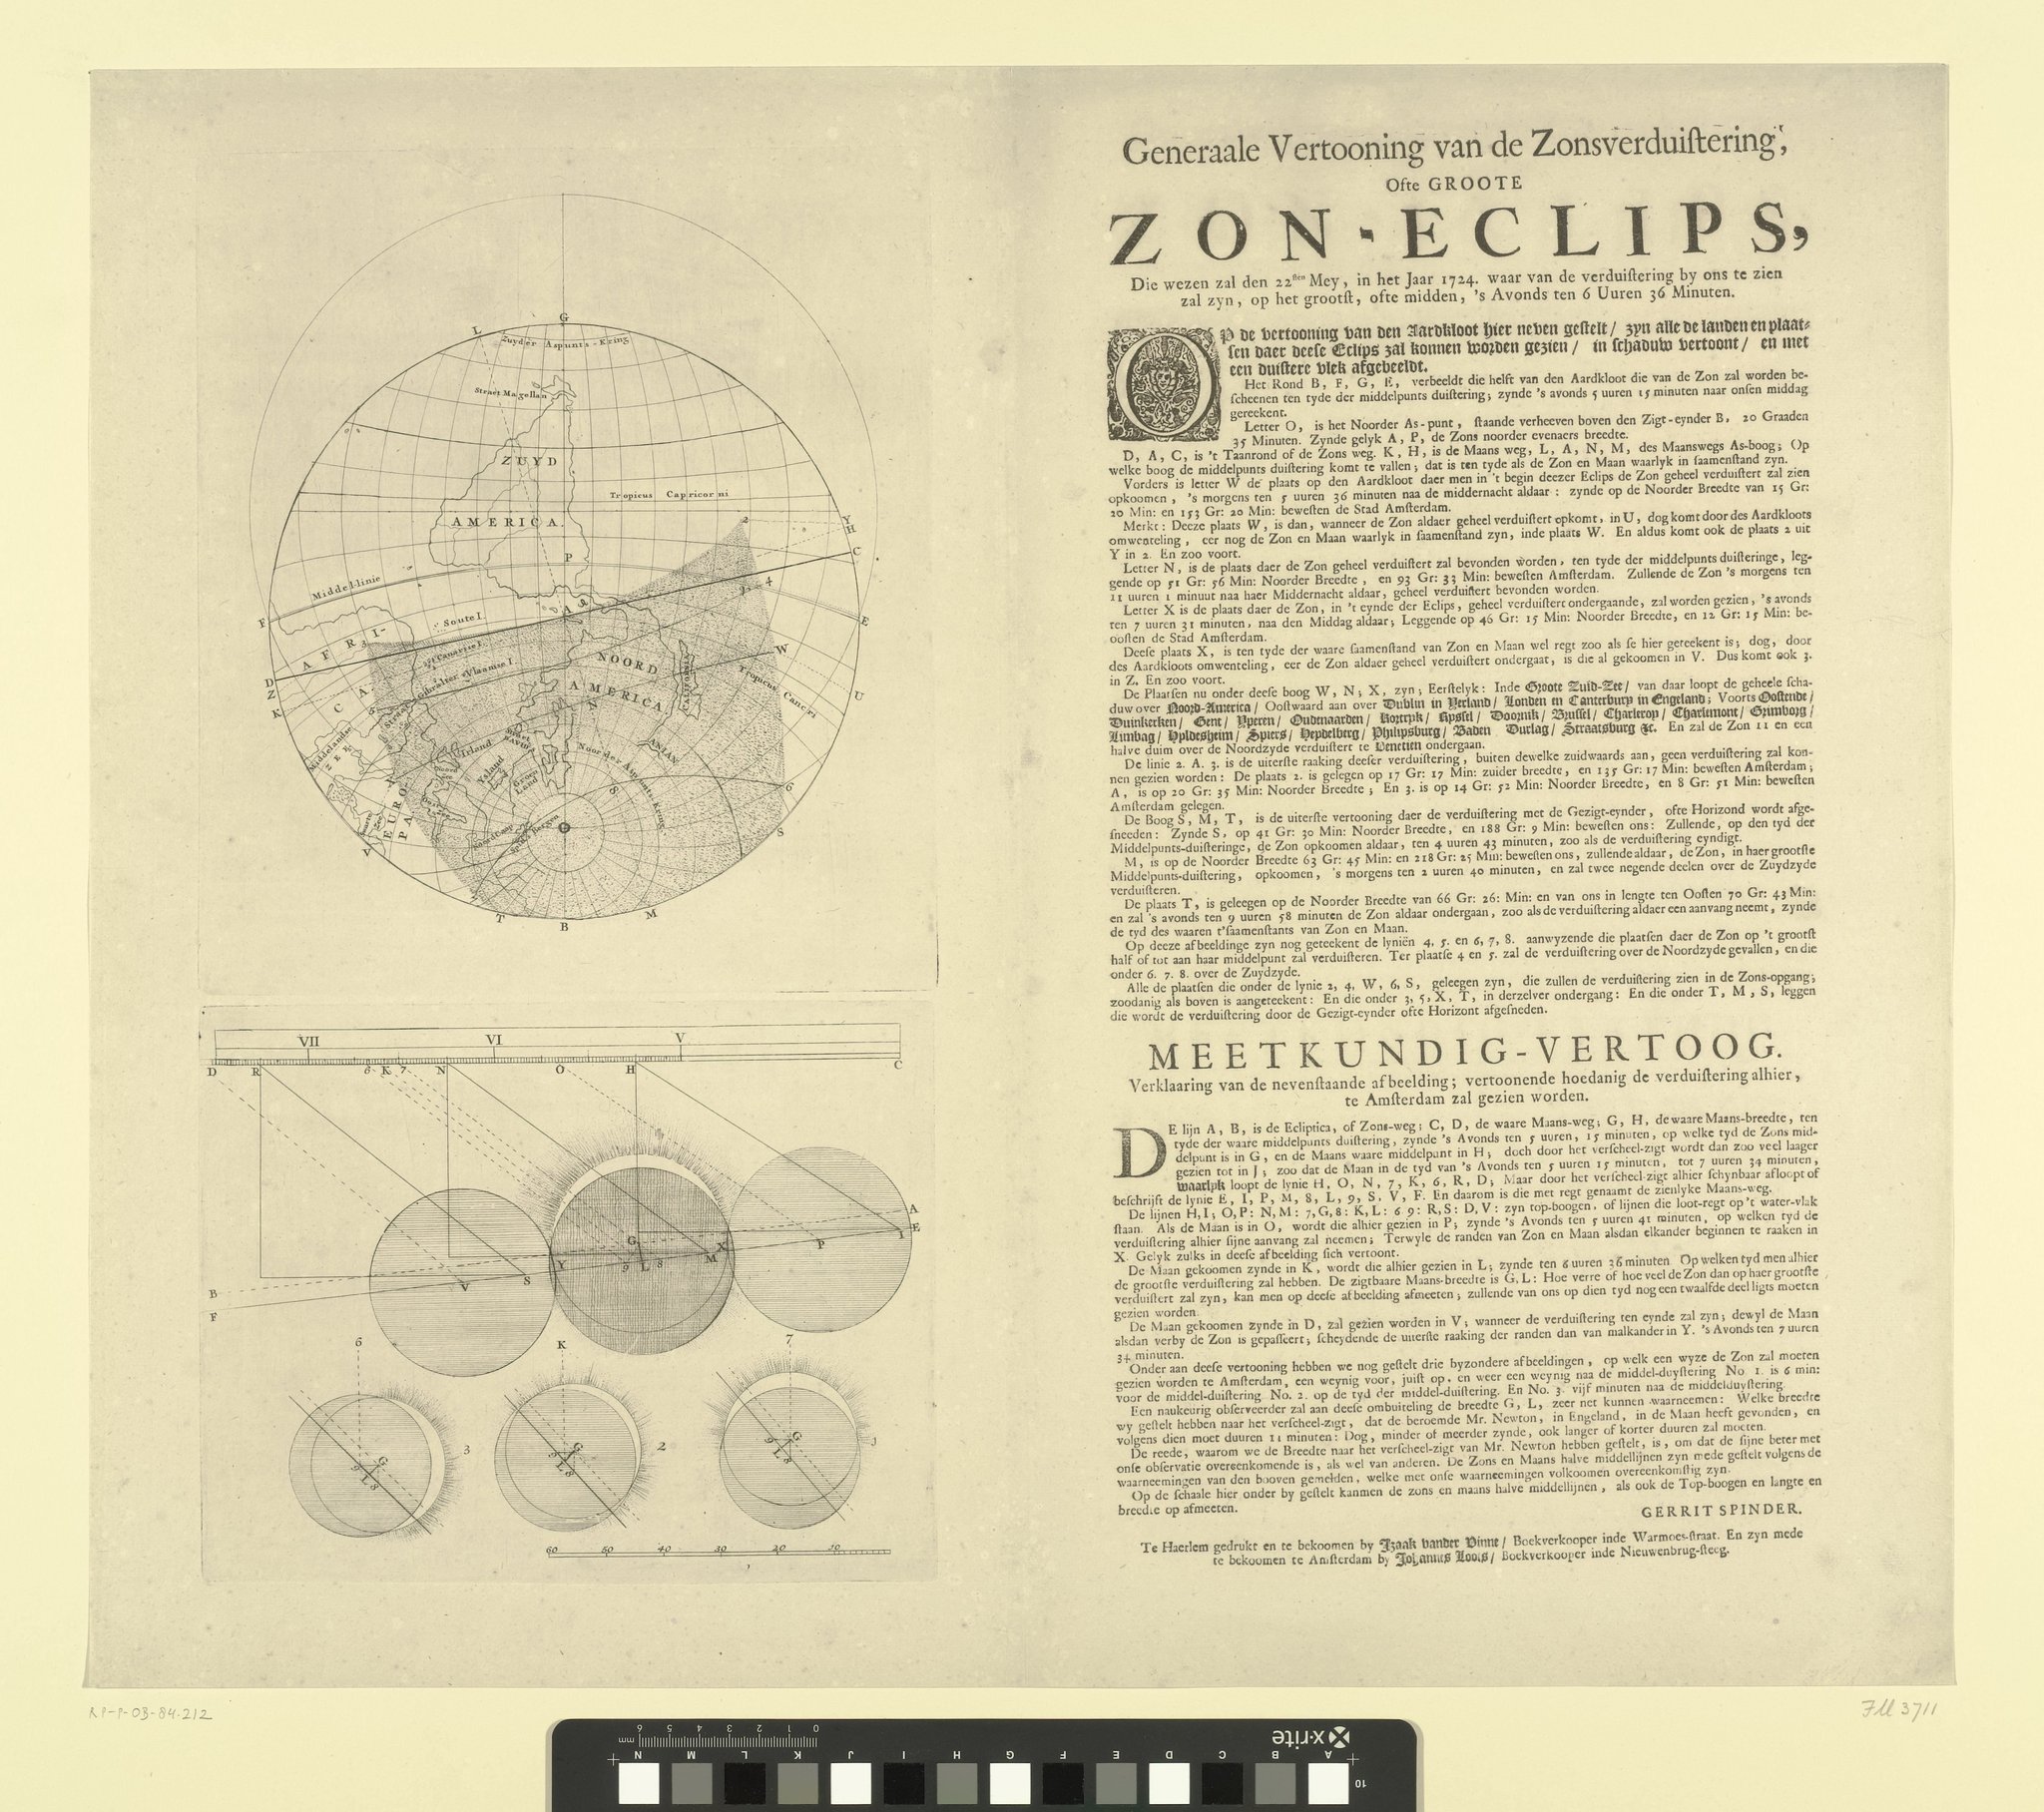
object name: print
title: Zonsverduistering van 22 mei 1724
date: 1724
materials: paper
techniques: engraving, etching, letterpress printing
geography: northern netherlands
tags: solar eclipse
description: Blad met een wereldkaart voor de totale zonsverduistering van 22 mei 1724, berekend en beschreven door de wis- en sterrenkundige Gerrit Spinder en waarop is aangegeven het gebied waar de zonsverduistering totaal of gedeeltelijk gezien kan worden. Op een tweede plaat staan meeetkundige diagrammen hoe de verduistering in Amsterdam te zien zal zijn.